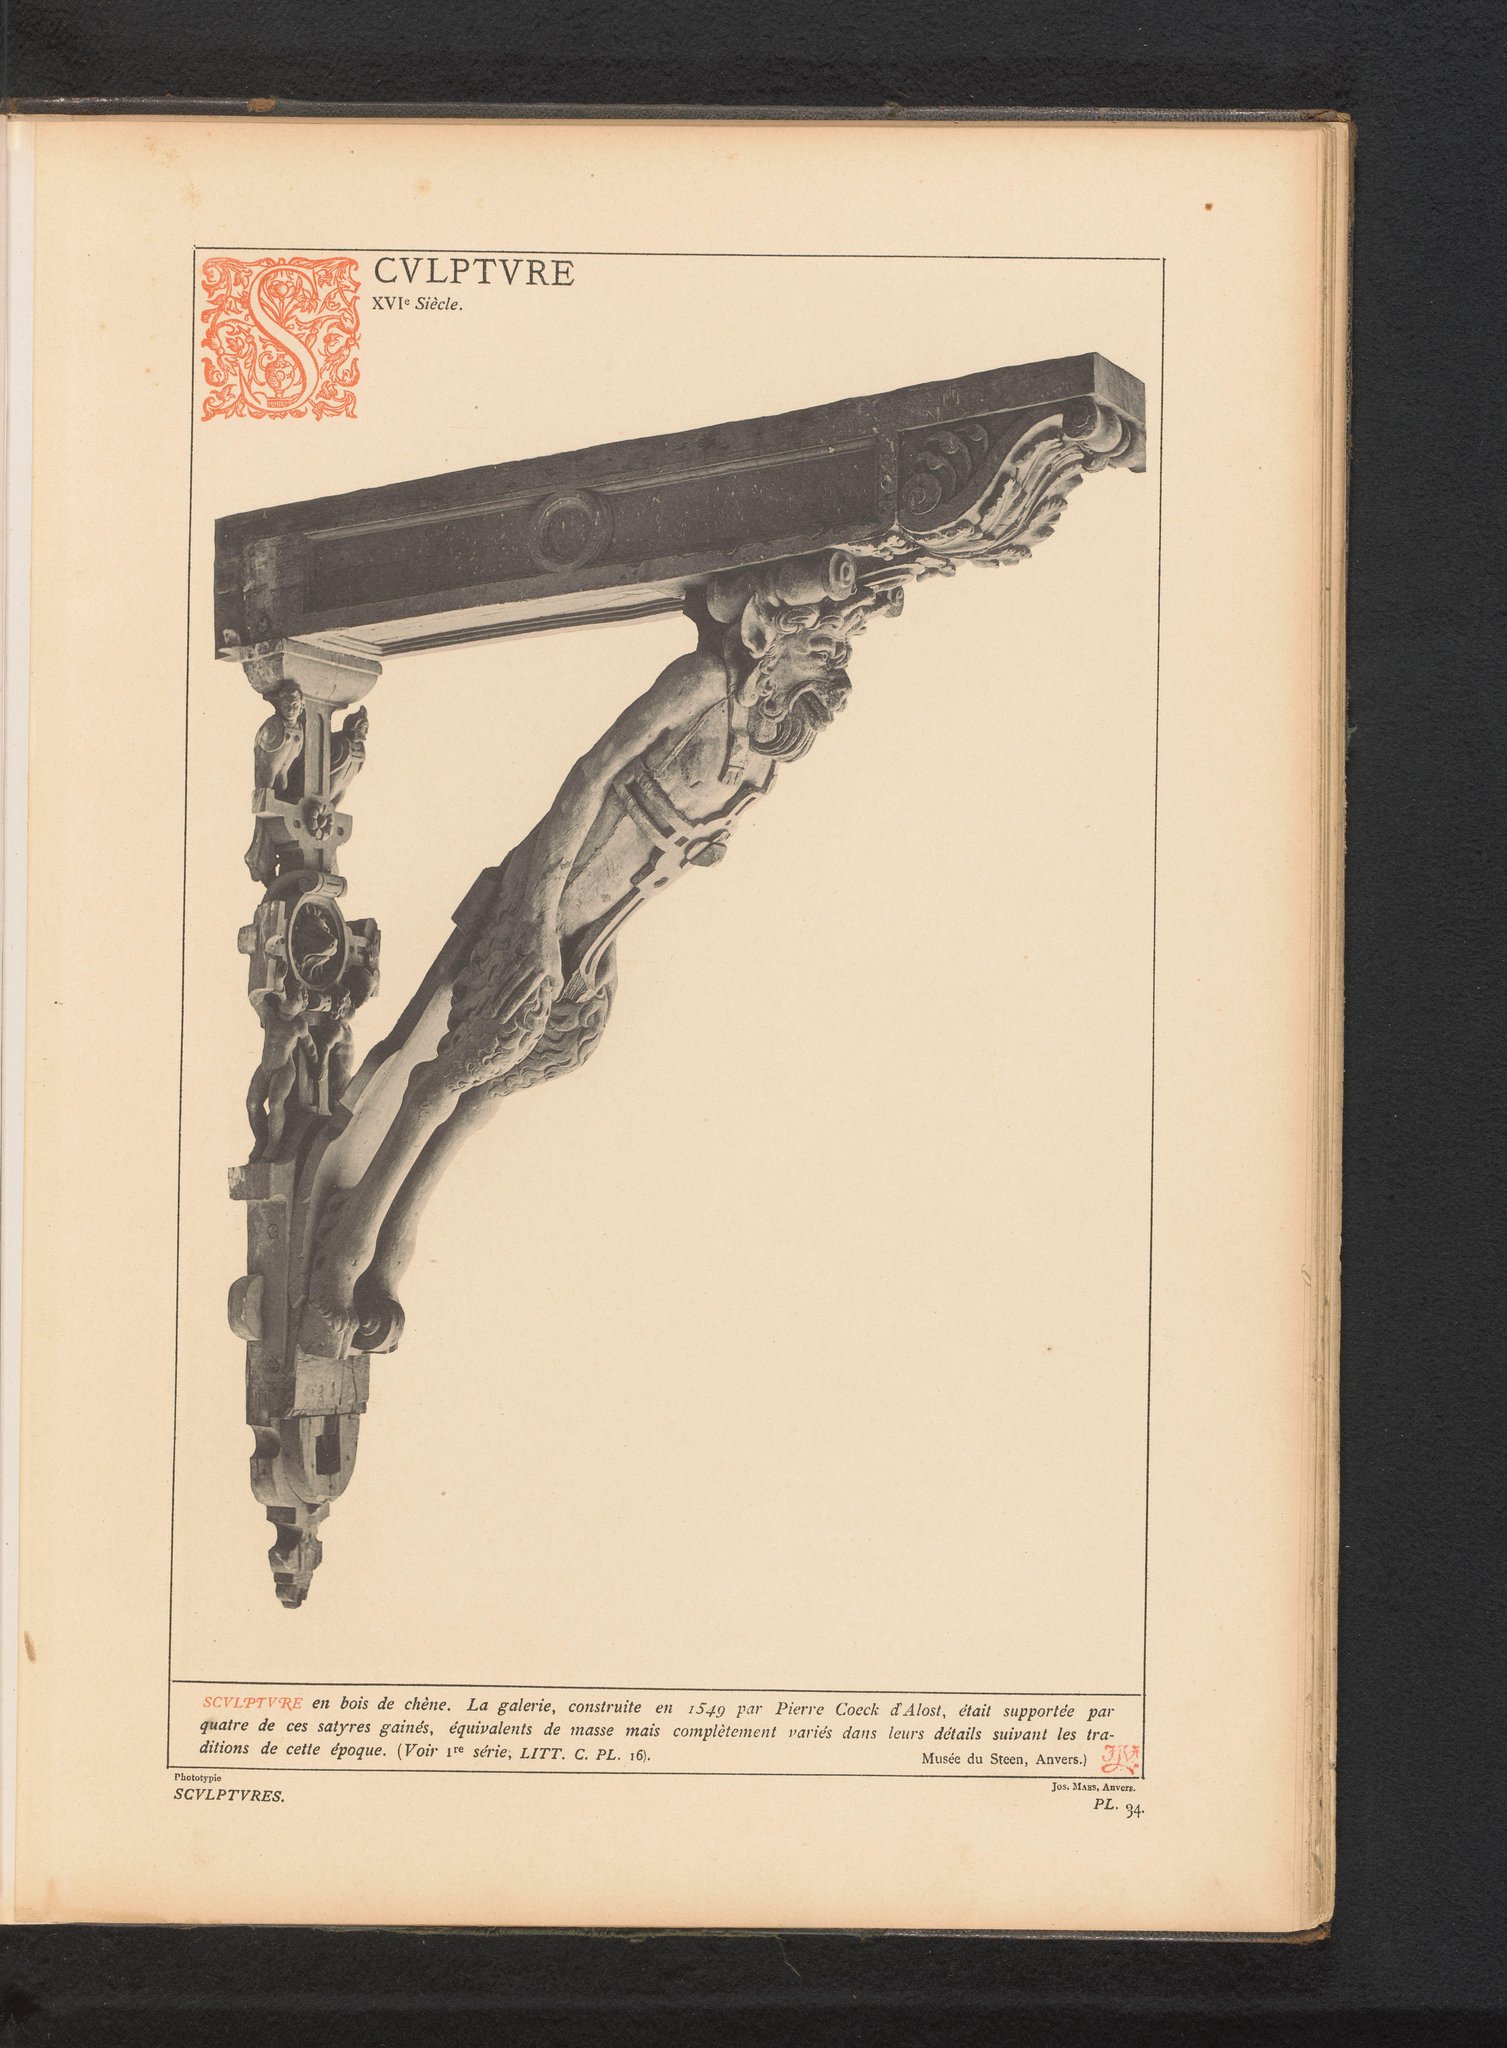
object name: photomechanical print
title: Sculpture, XVIe Siècle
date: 1881-1889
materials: paper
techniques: photograph, photolithography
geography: antwerp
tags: satyr(s) (in general), sculpture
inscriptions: inscription: ‘SCULPTURE en bois (...)’, inscription: ‘SCULPTURES. PL. 34.’, monogram: ‘JJvY’